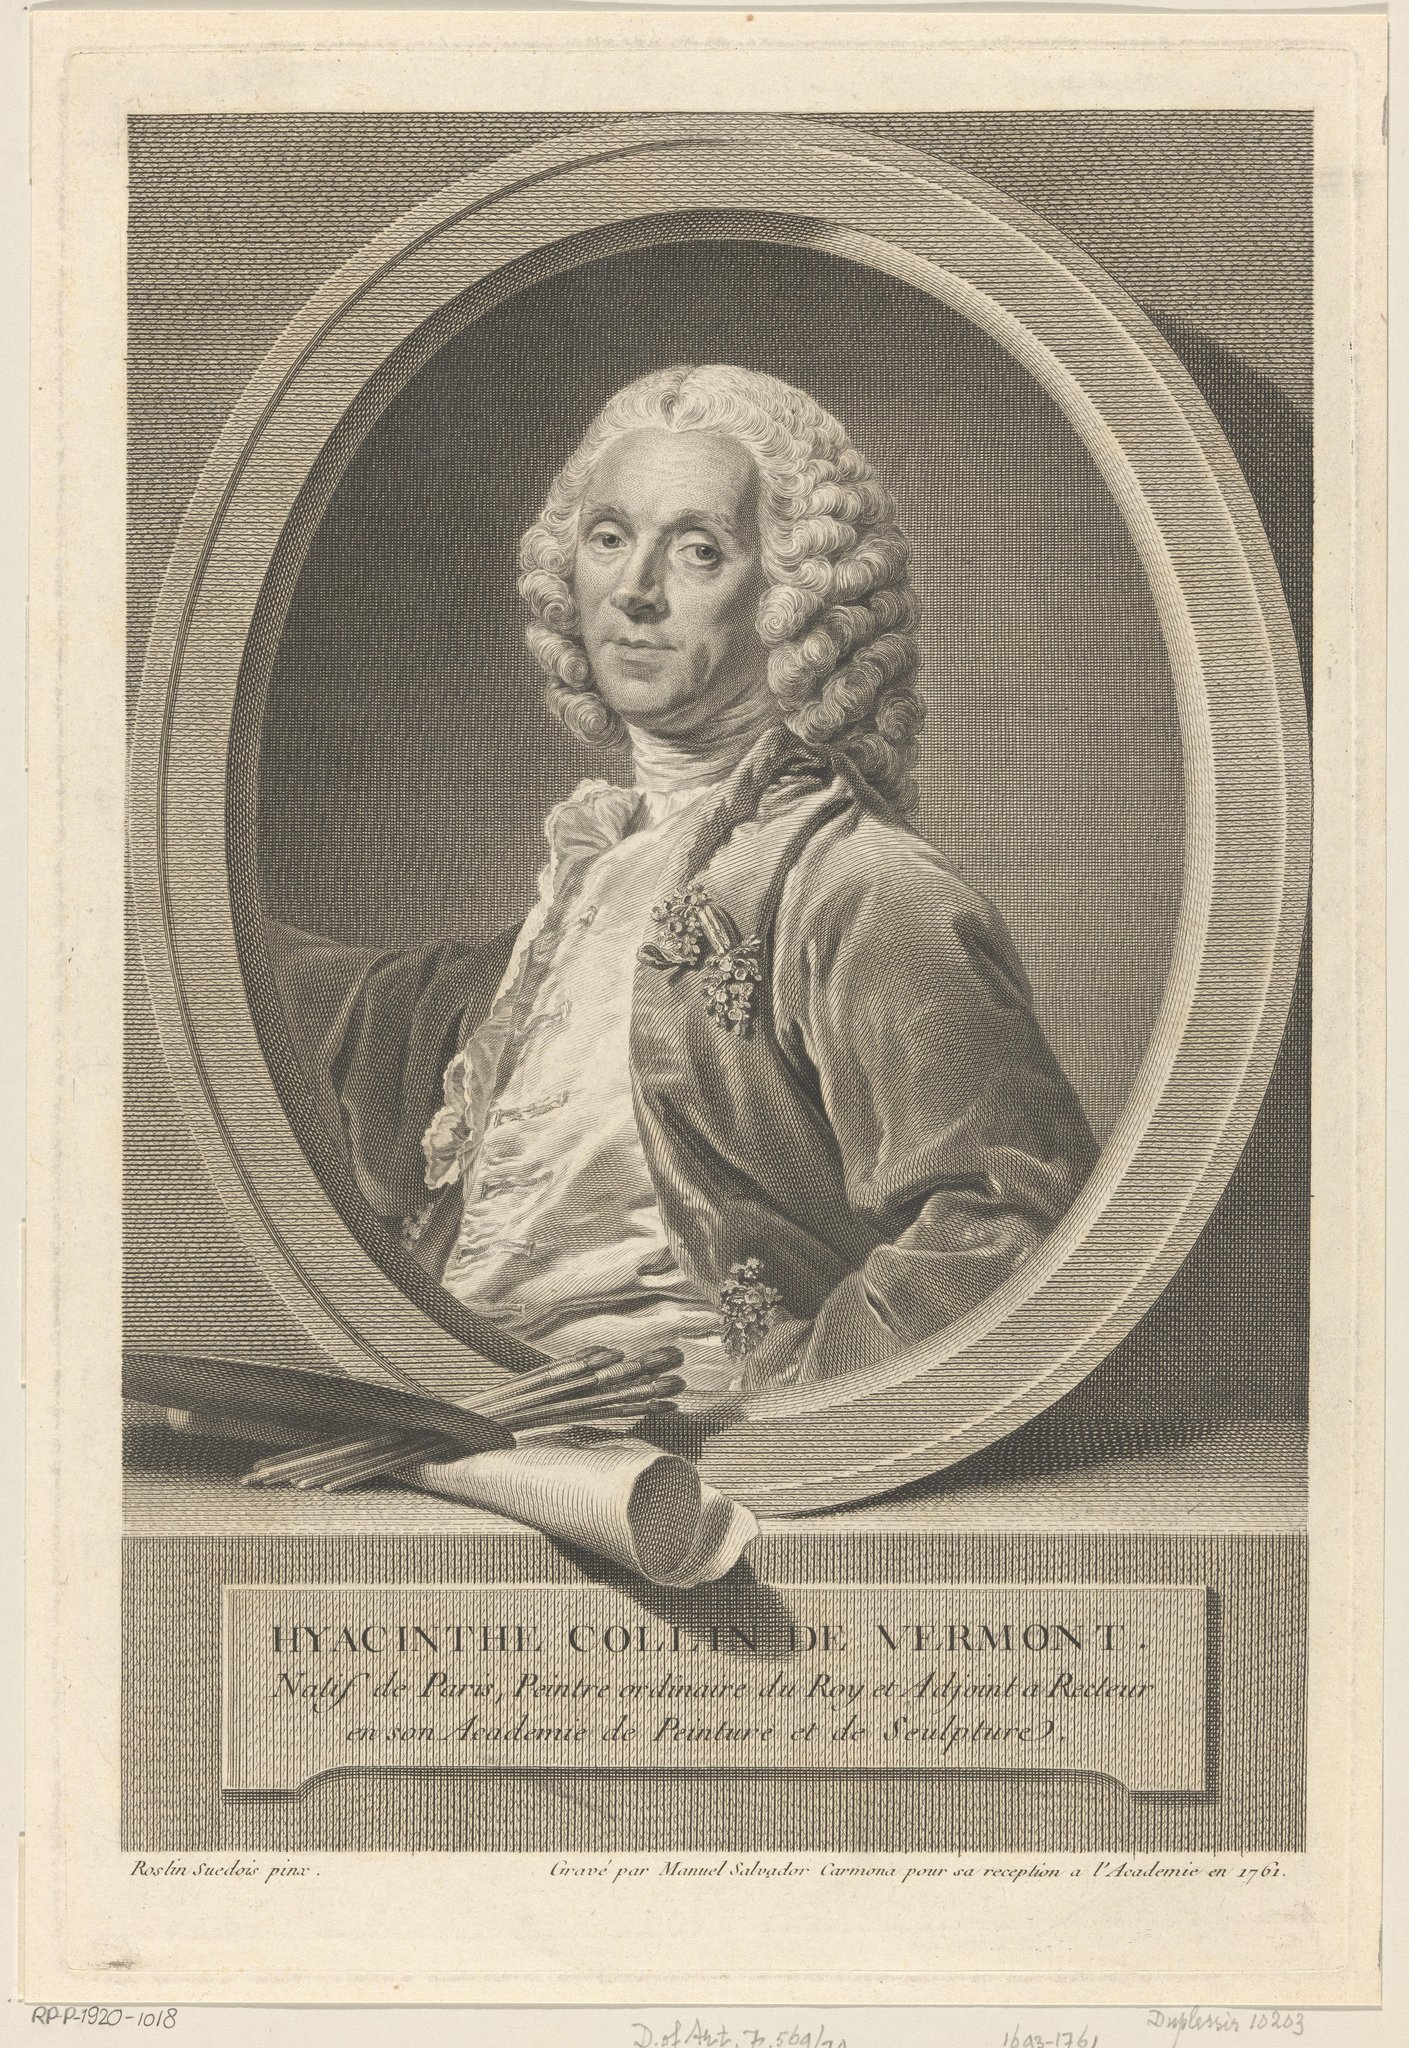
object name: print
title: Portret van schilder Hyacinthe Collin de Vermont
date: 1761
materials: paper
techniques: engraving, etching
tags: painter, historical persons, portrait, self-portrait of painter, tools, implements of painter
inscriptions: collector's mark: Lugt 2228